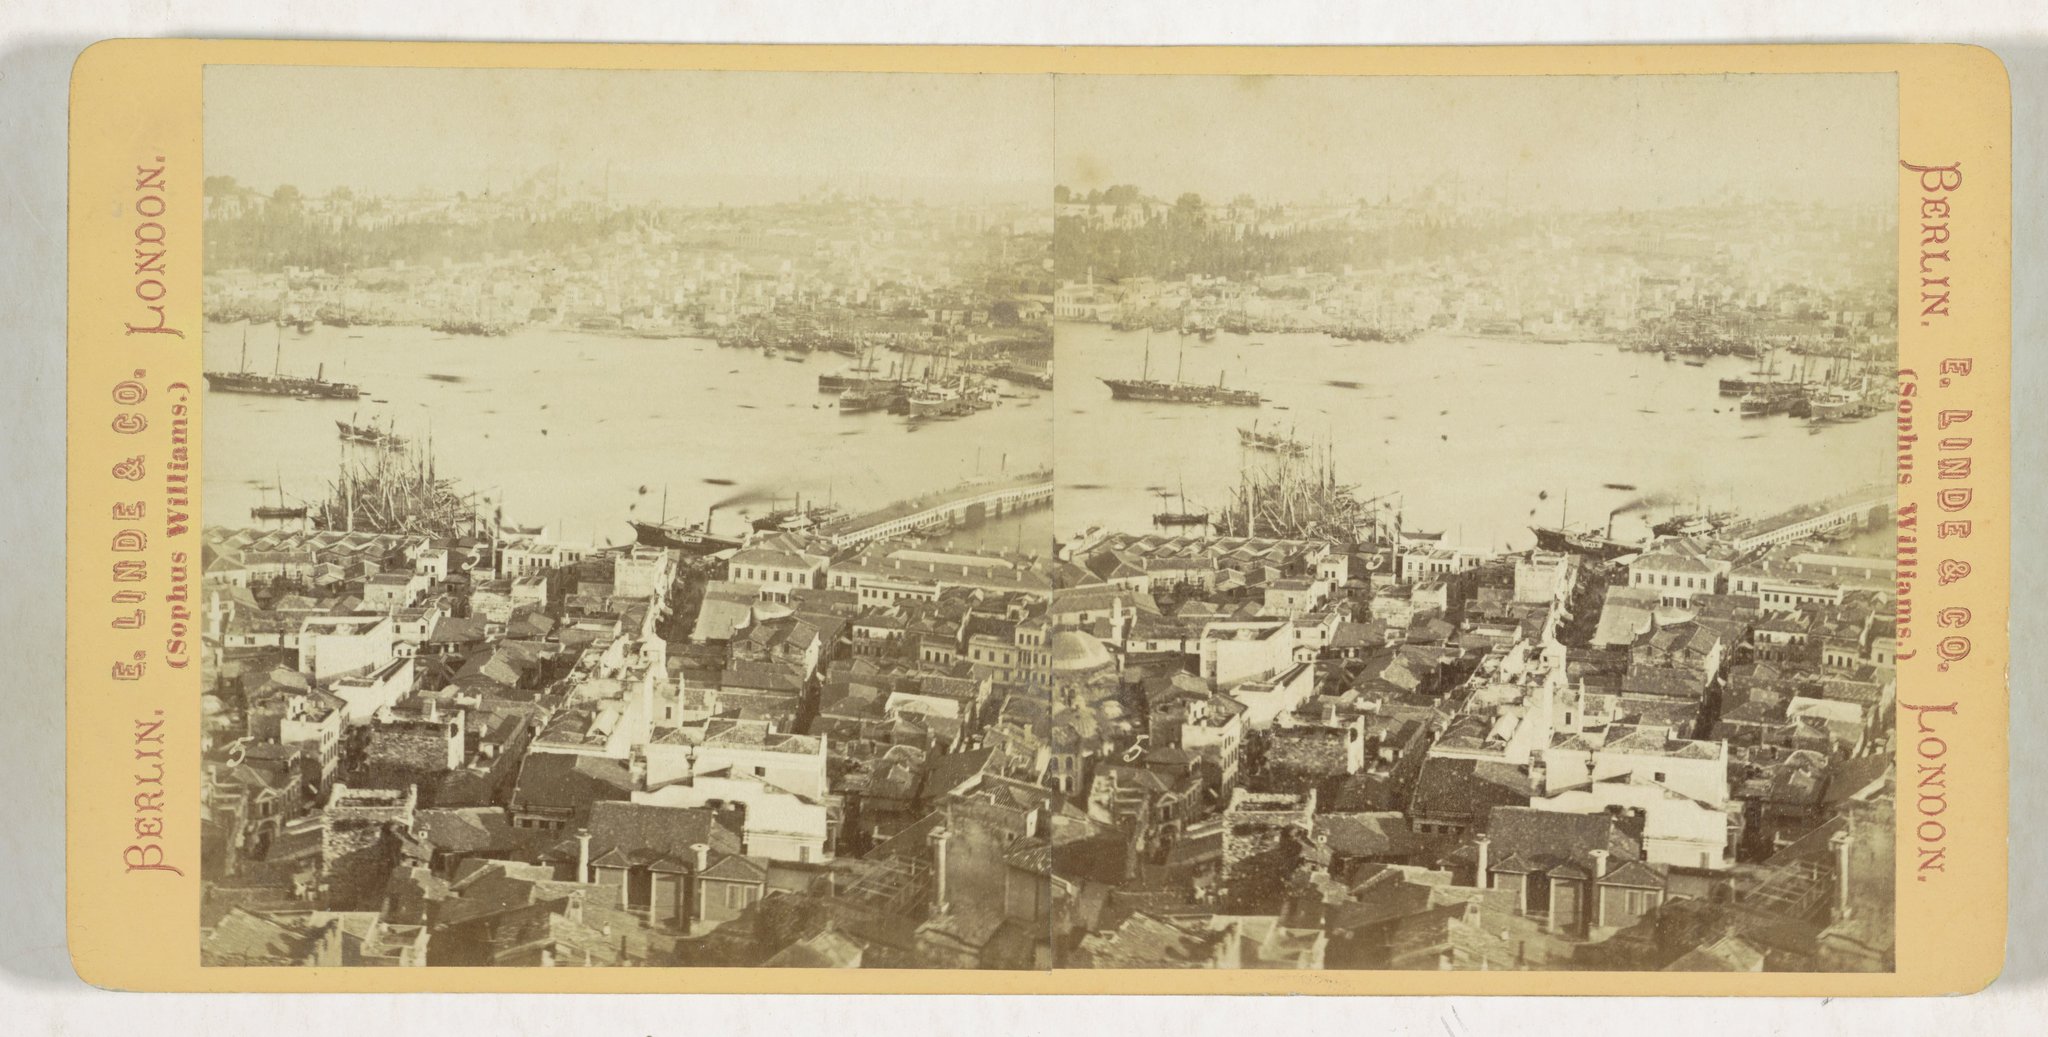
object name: stereograph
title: Panorama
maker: Anonymous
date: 1873-1890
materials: cardboard, paper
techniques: albumen print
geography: istanbul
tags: city-view in general; 'veduta'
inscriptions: number: ‘5’